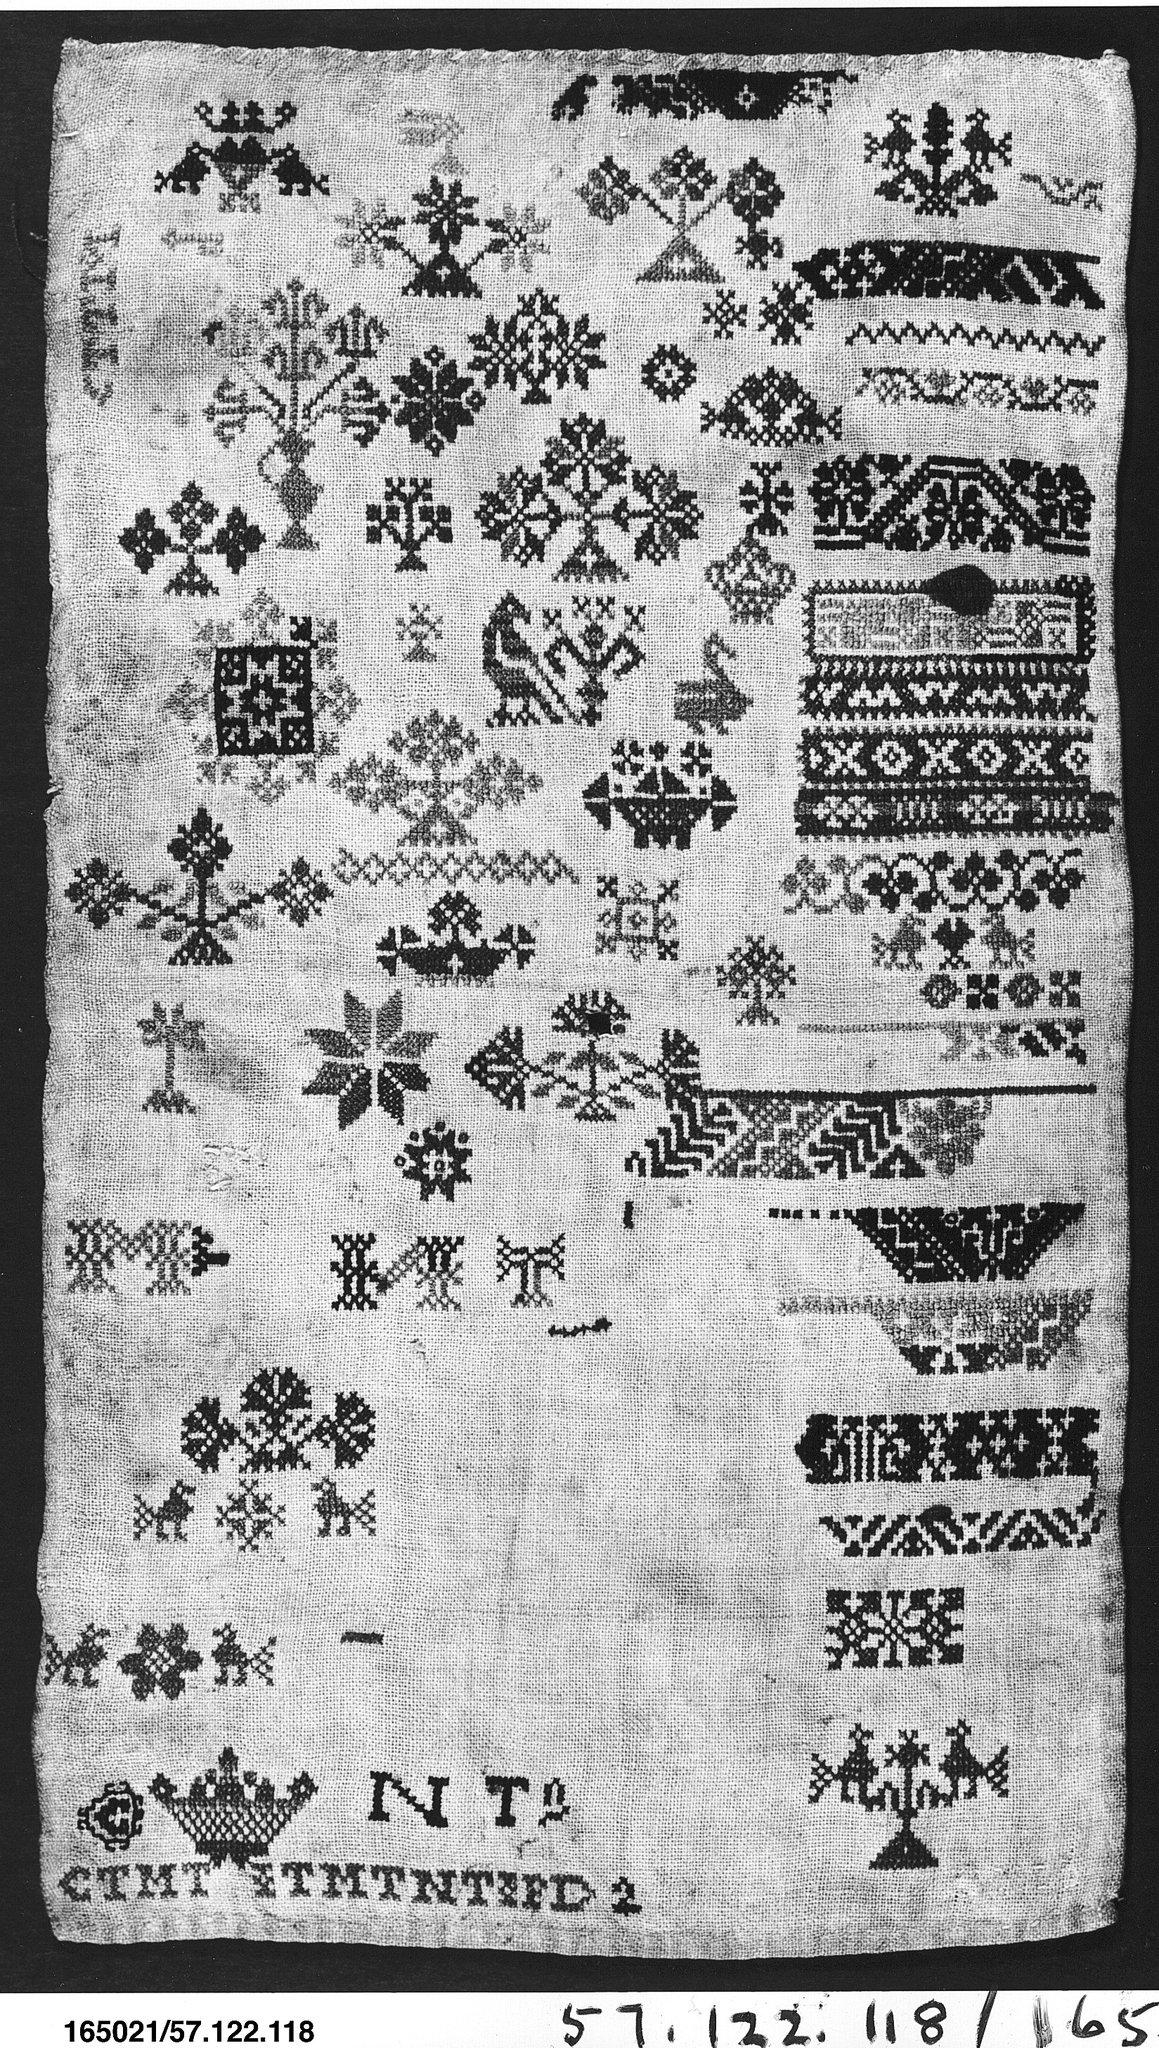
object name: sampler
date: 1701-1800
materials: linen, silk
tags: flowers